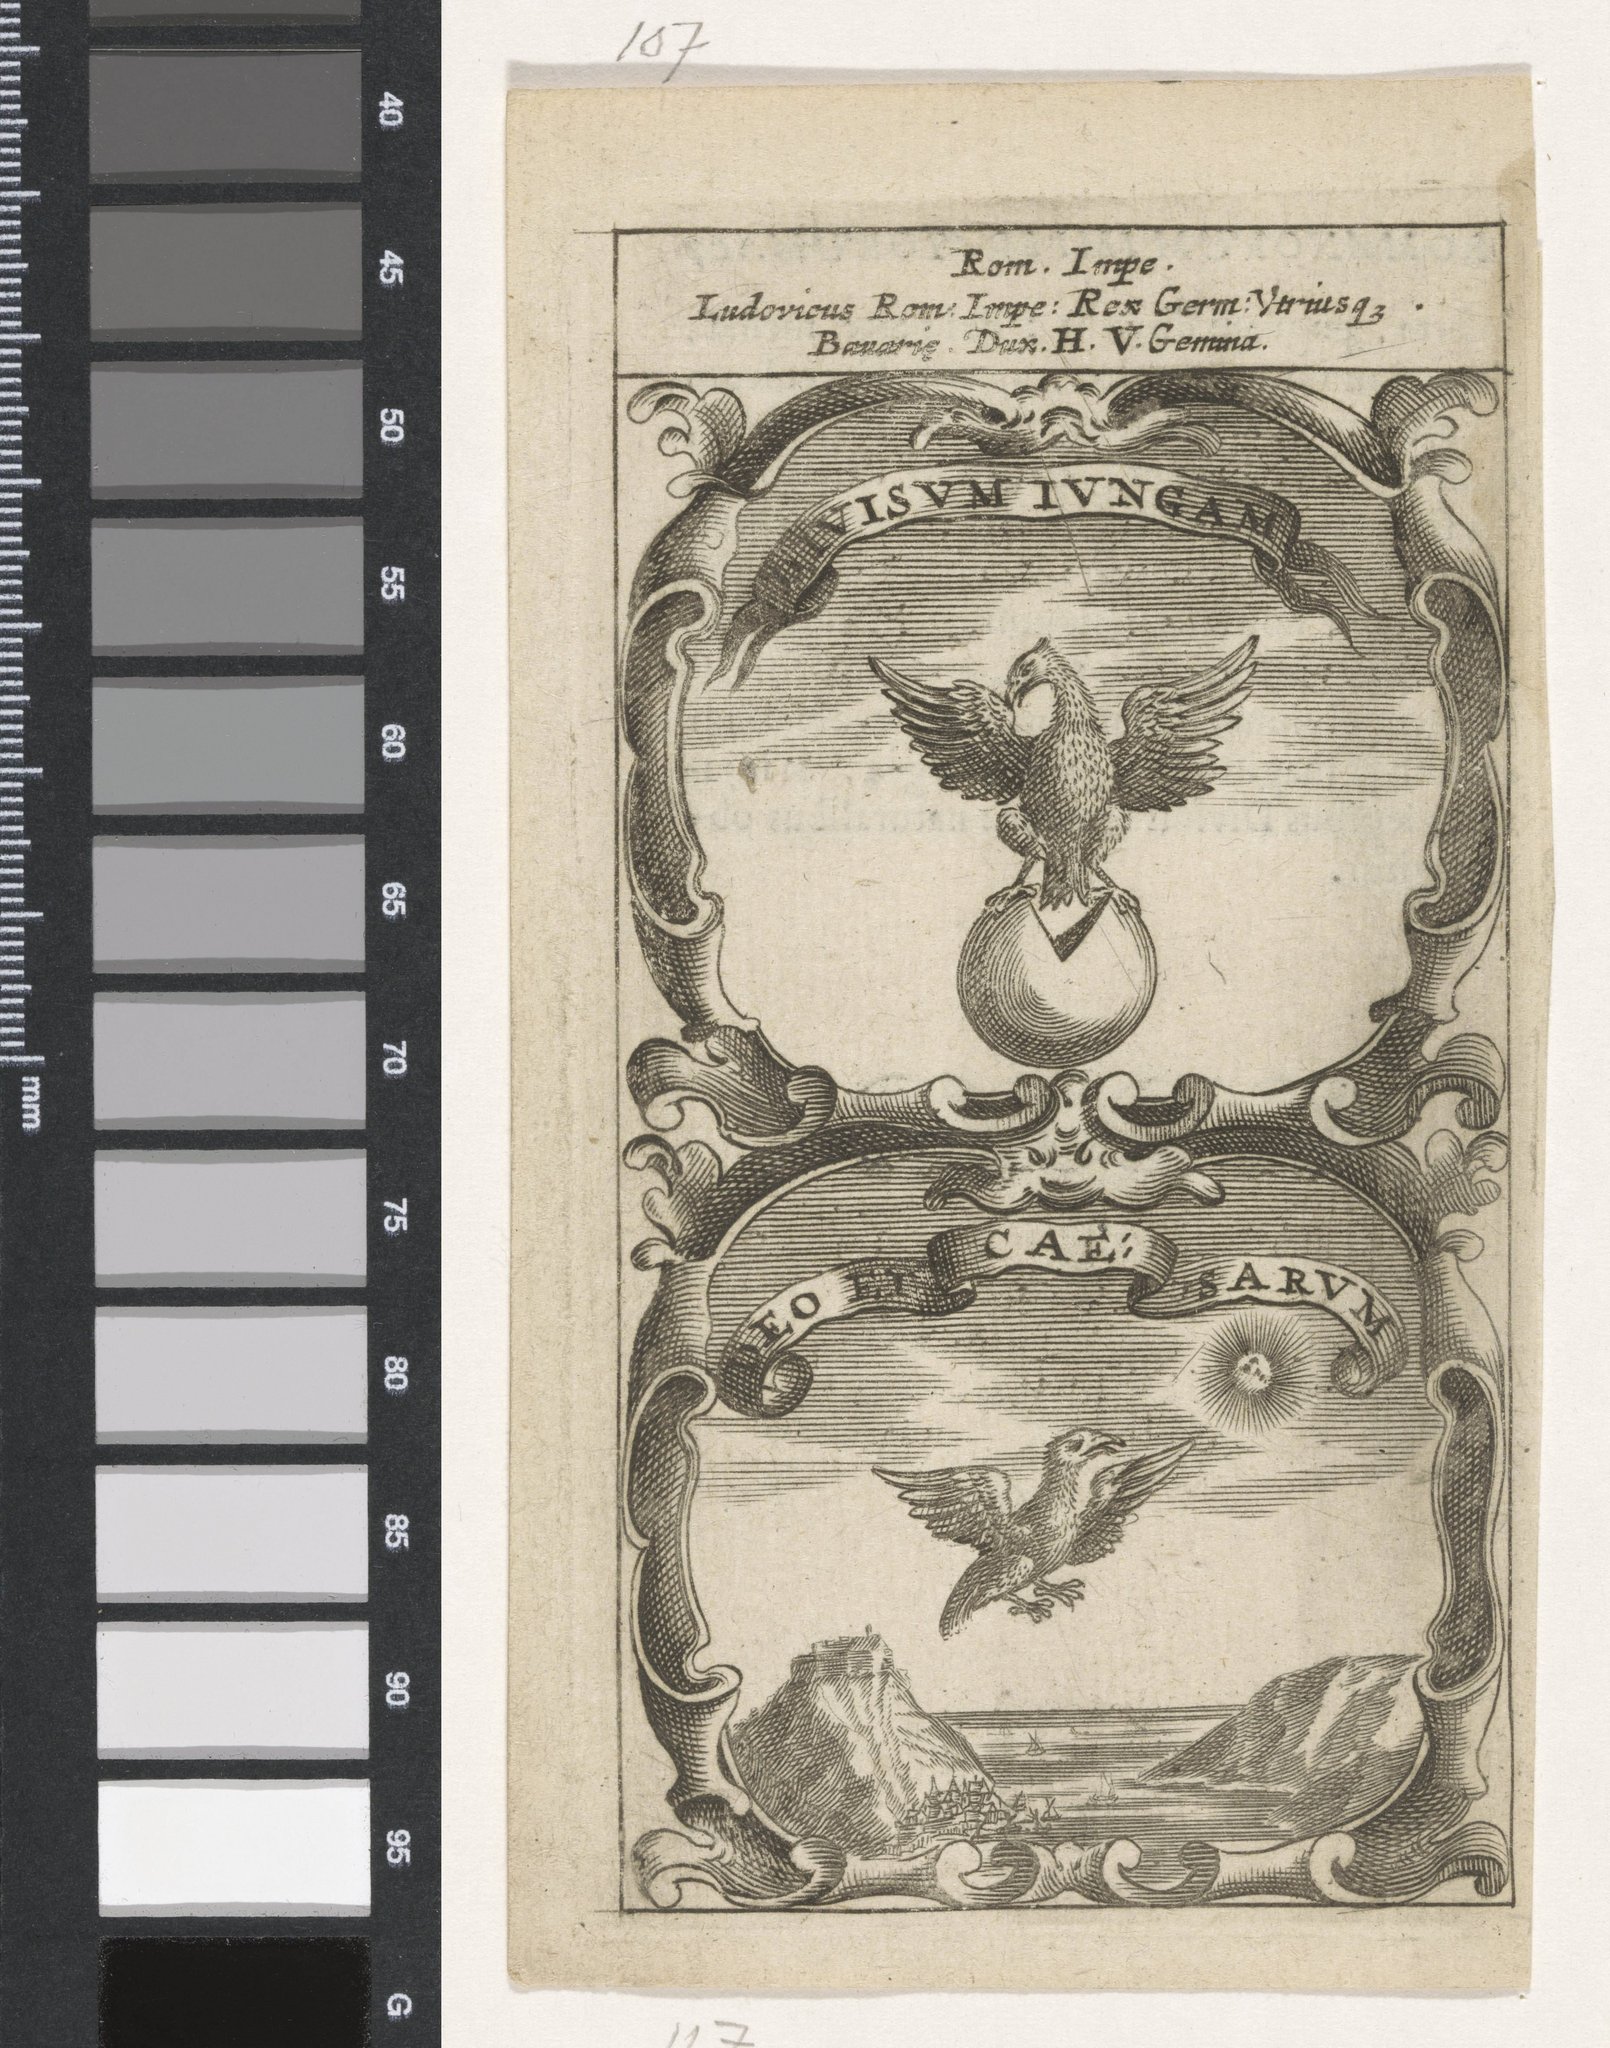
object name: book illustration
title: Divisum Jungam / Deo Et Caesarum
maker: Anonymous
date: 1666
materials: paper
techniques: engraving, letterpress printing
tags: birds, globe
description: Een embleem met twee voorstellingen. Boven zit een arend met zijn klauwen op een gespleten wereld. Onder vliegt een vogel boven een landschap met de monding van een rivier. Boven hem de zon. Het betreffen deviezen van keizer Lodewijk de Beier.